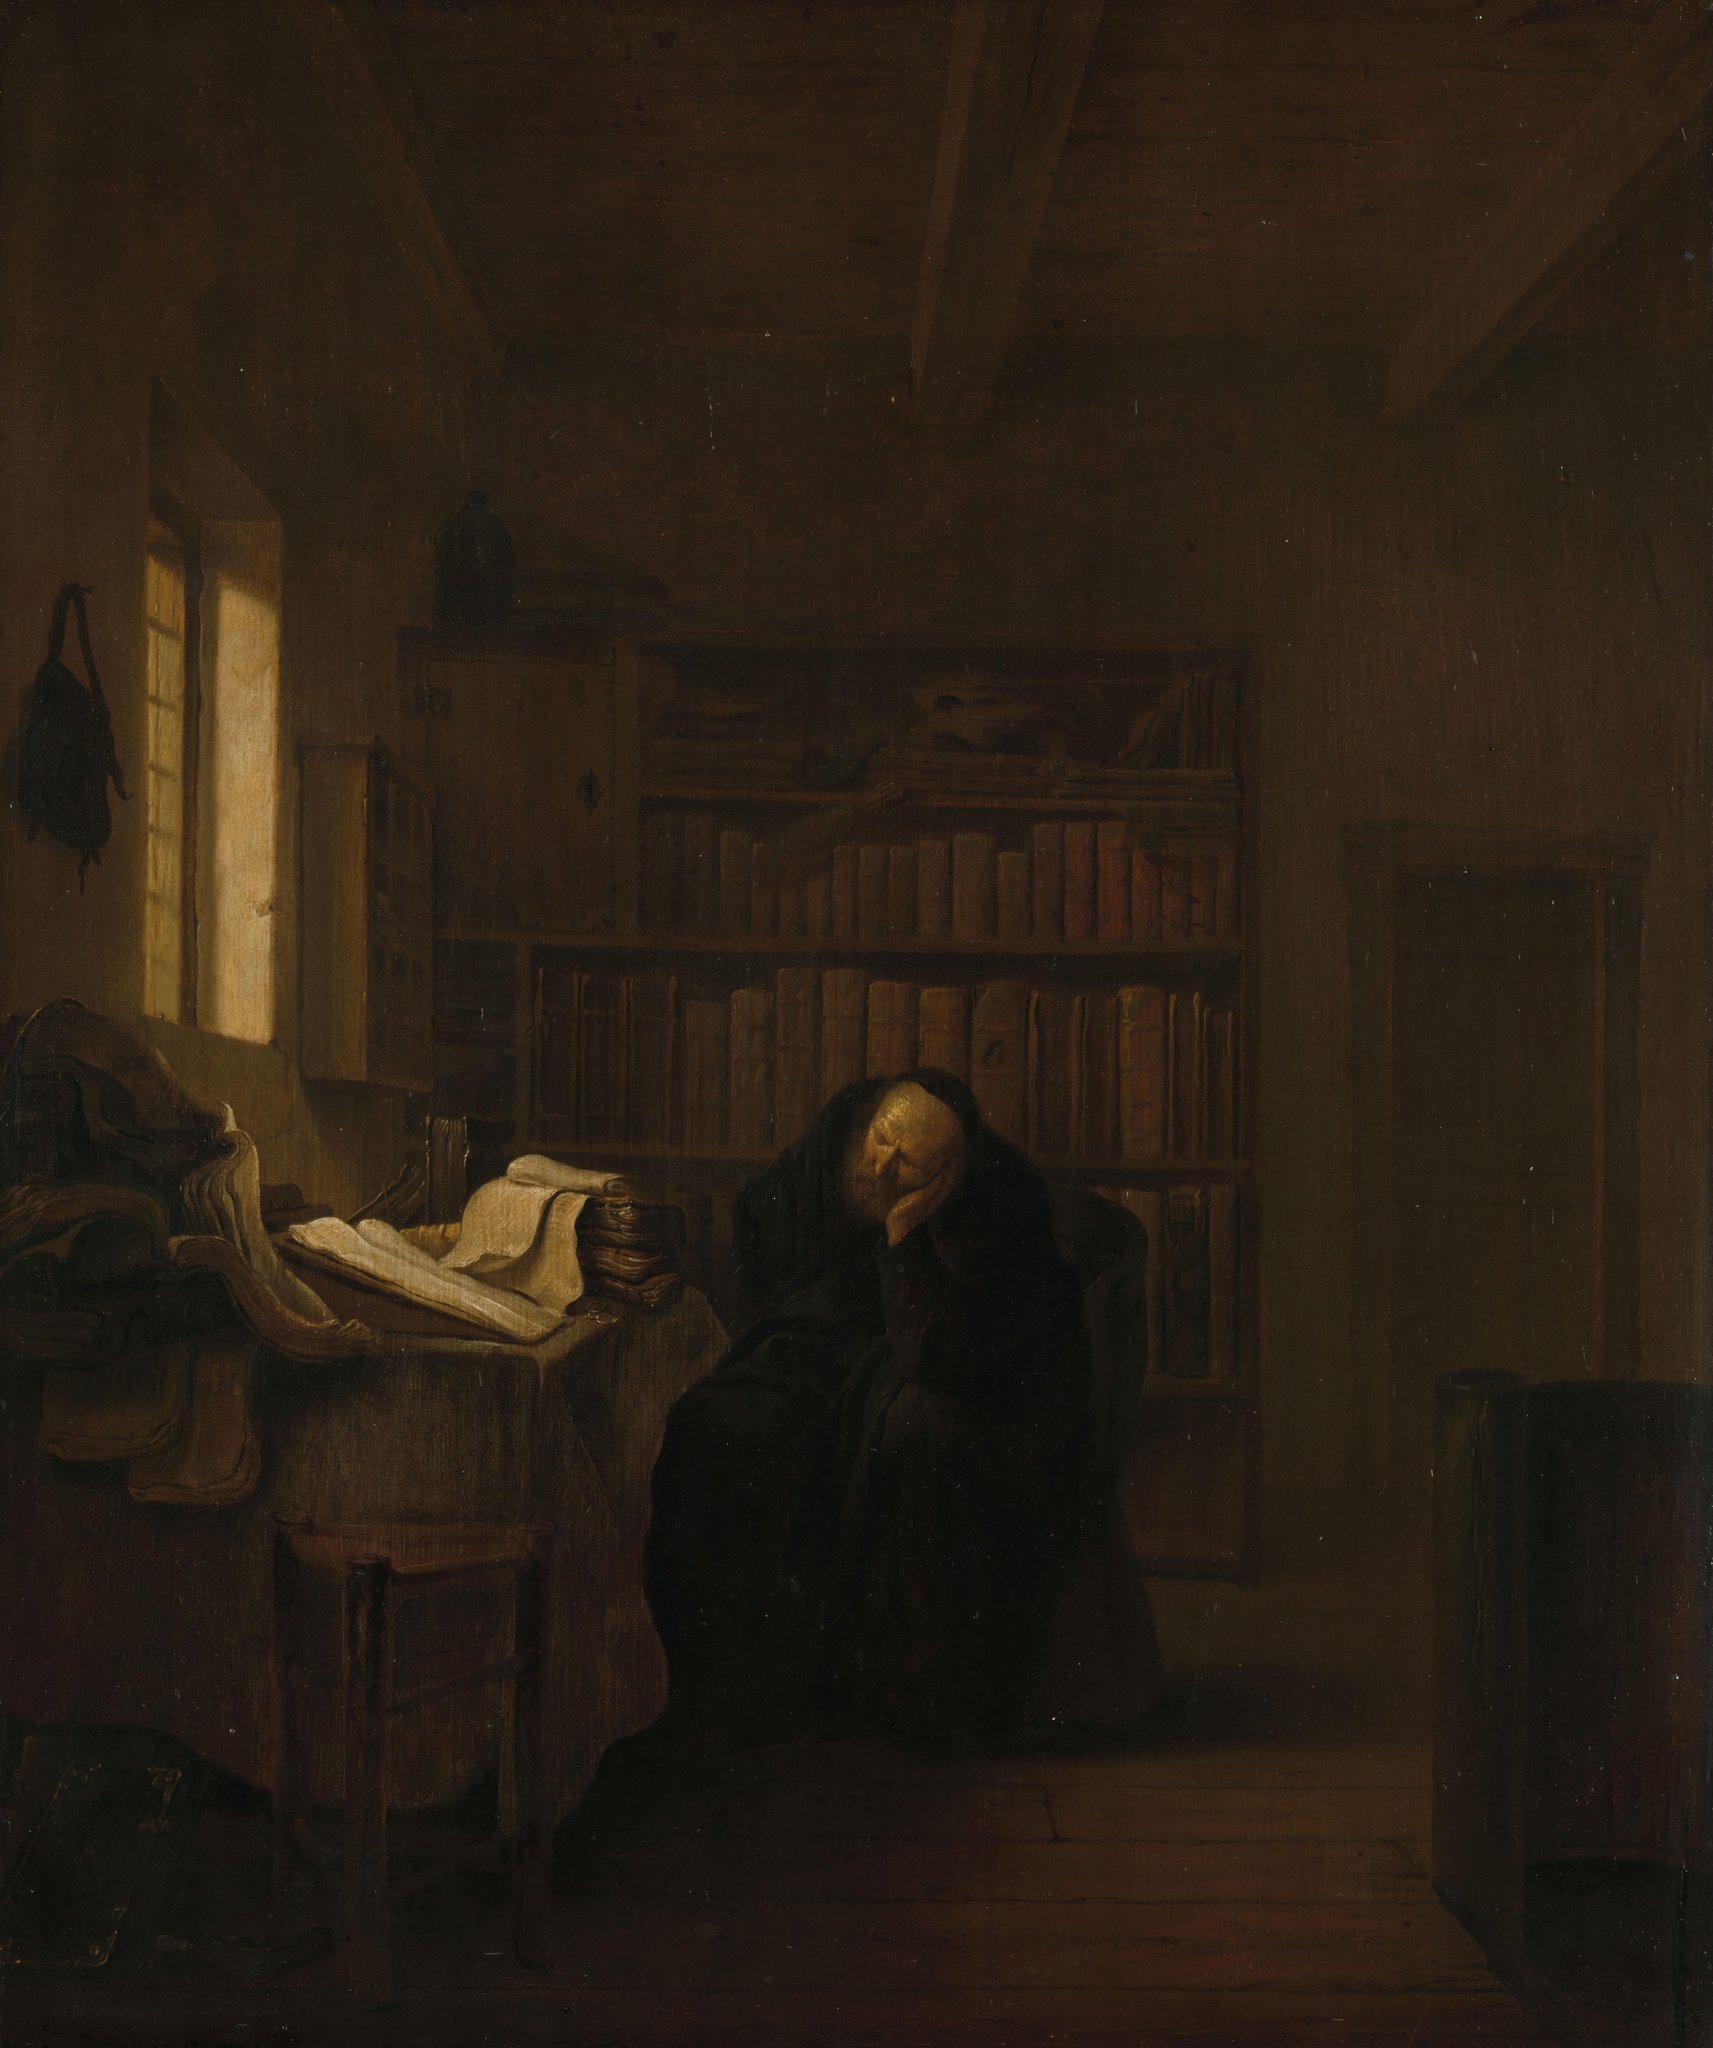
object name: painting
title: A Scholar in his Study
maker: willem de poorter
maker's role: painter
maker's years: 1608-1648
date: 1642-1650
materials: oil, panel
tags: scholar in his study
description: Interieur van een studeerkamer waar een geleerde in zijn stoel achter een tafel in slaap is gevallen, met de hoofd steunend op de linkerhand. Op tafel liggen grote stapels boeken en paperassen. Tegen de achtermuur een kast met boeken.